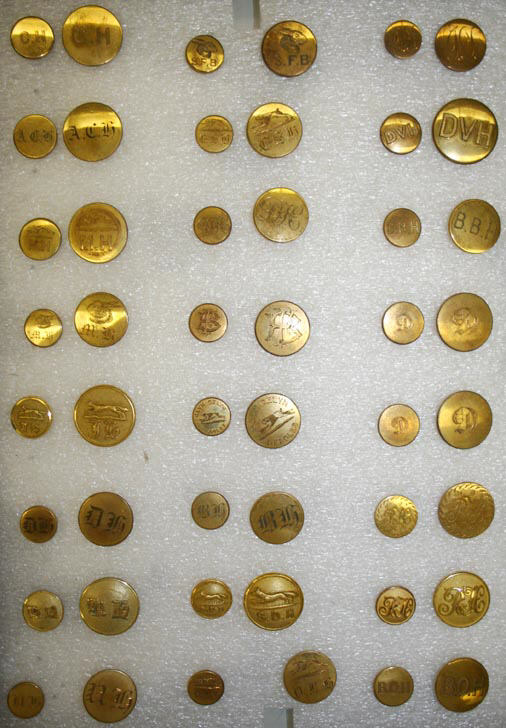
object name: button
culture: british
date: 1850-1880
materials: metal